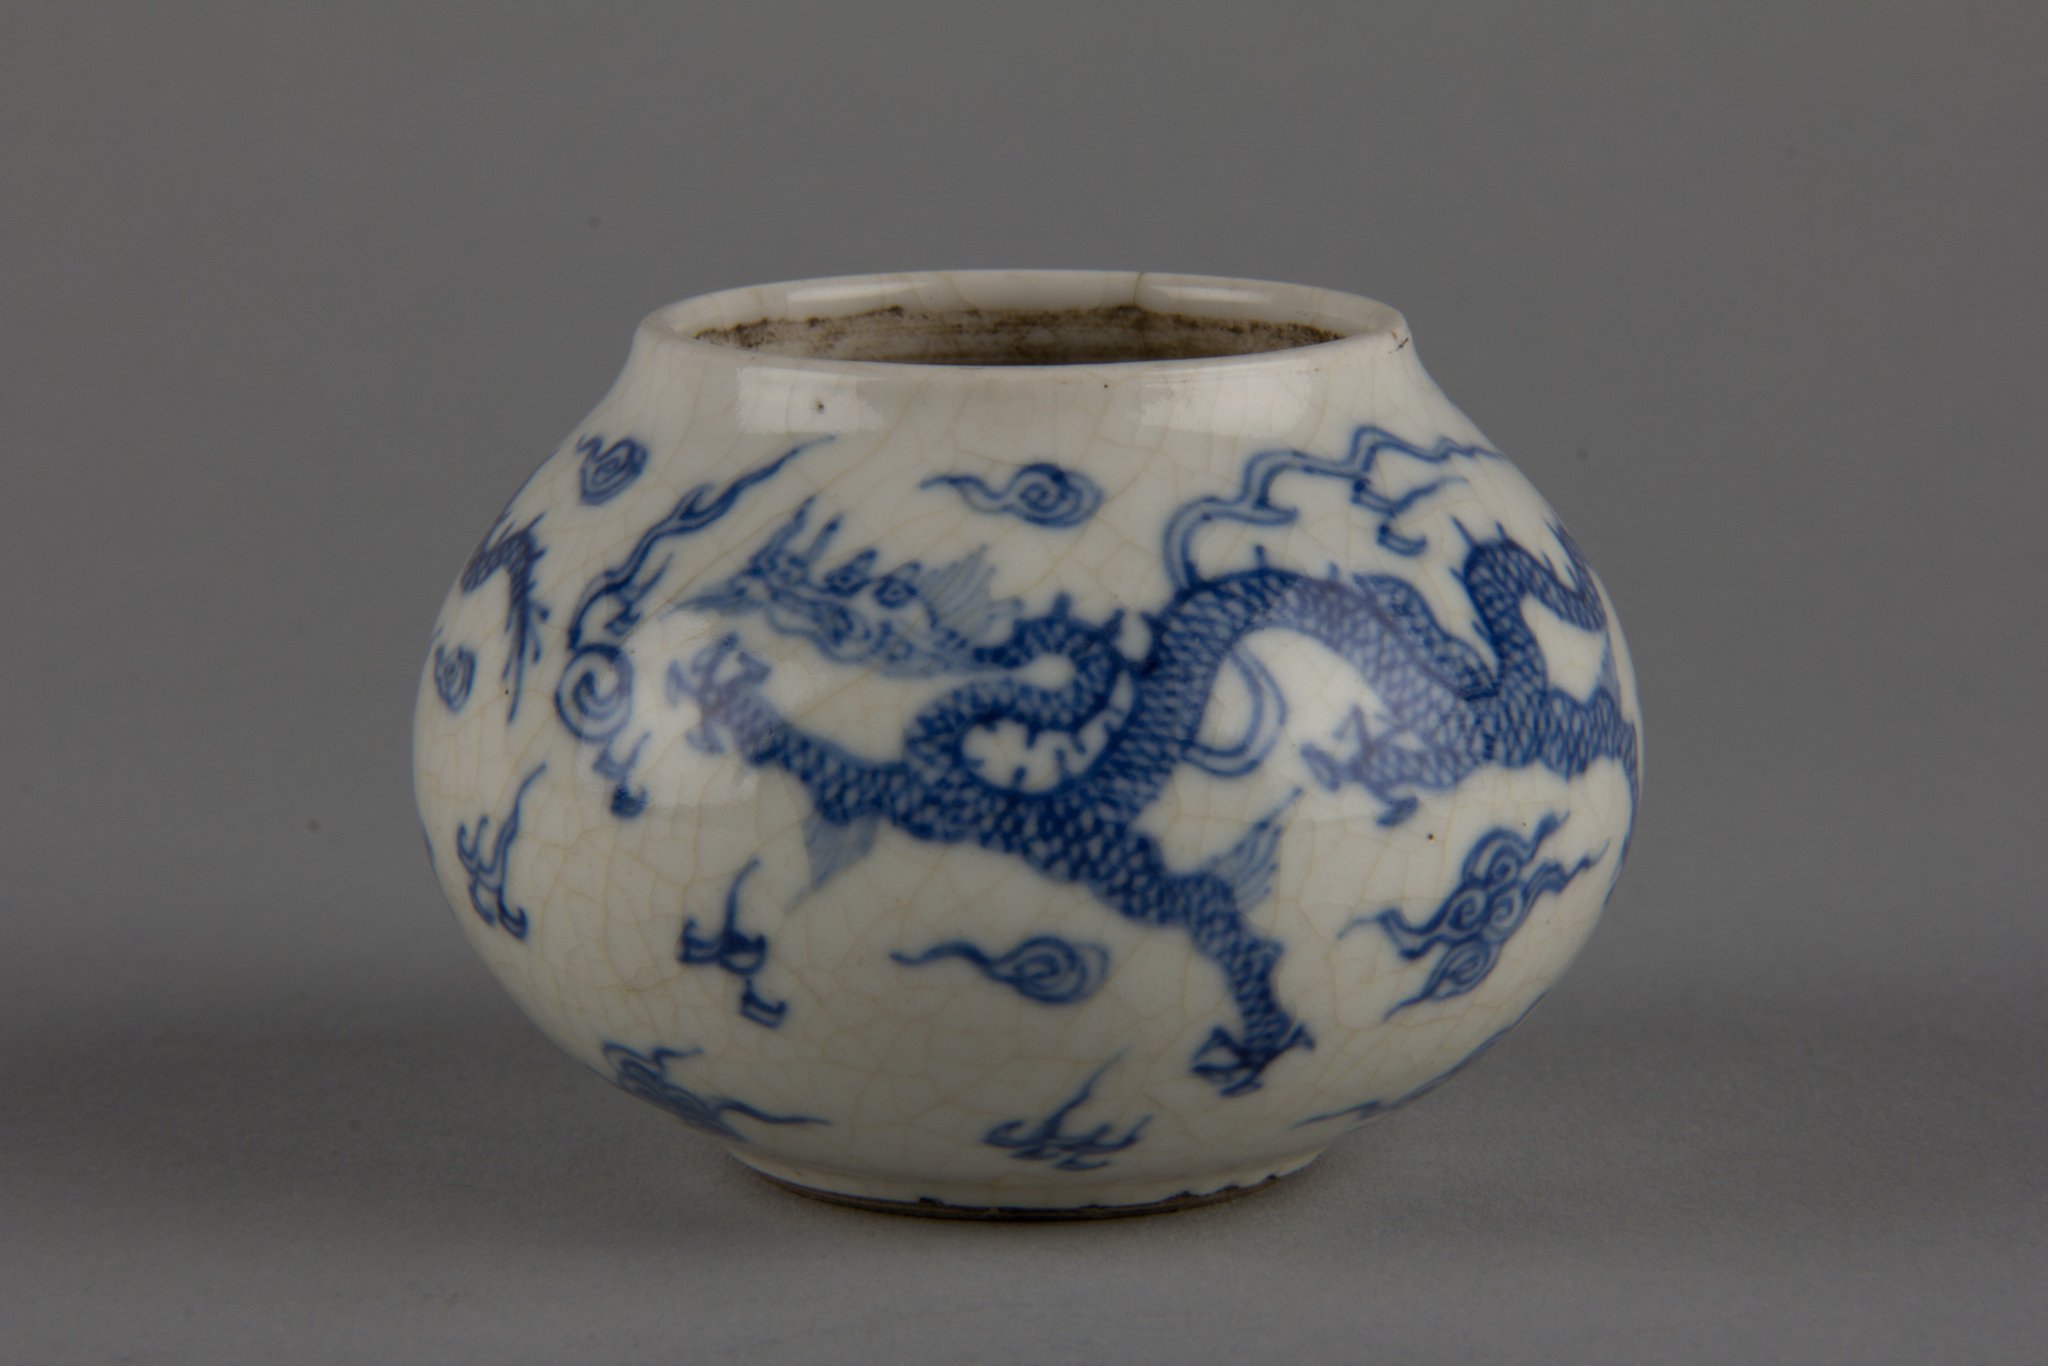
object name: water pot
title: Water pot with dragon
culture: chinese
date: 1701-1733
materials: cobalt, porcelain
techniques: painting, underglaze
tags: dragons